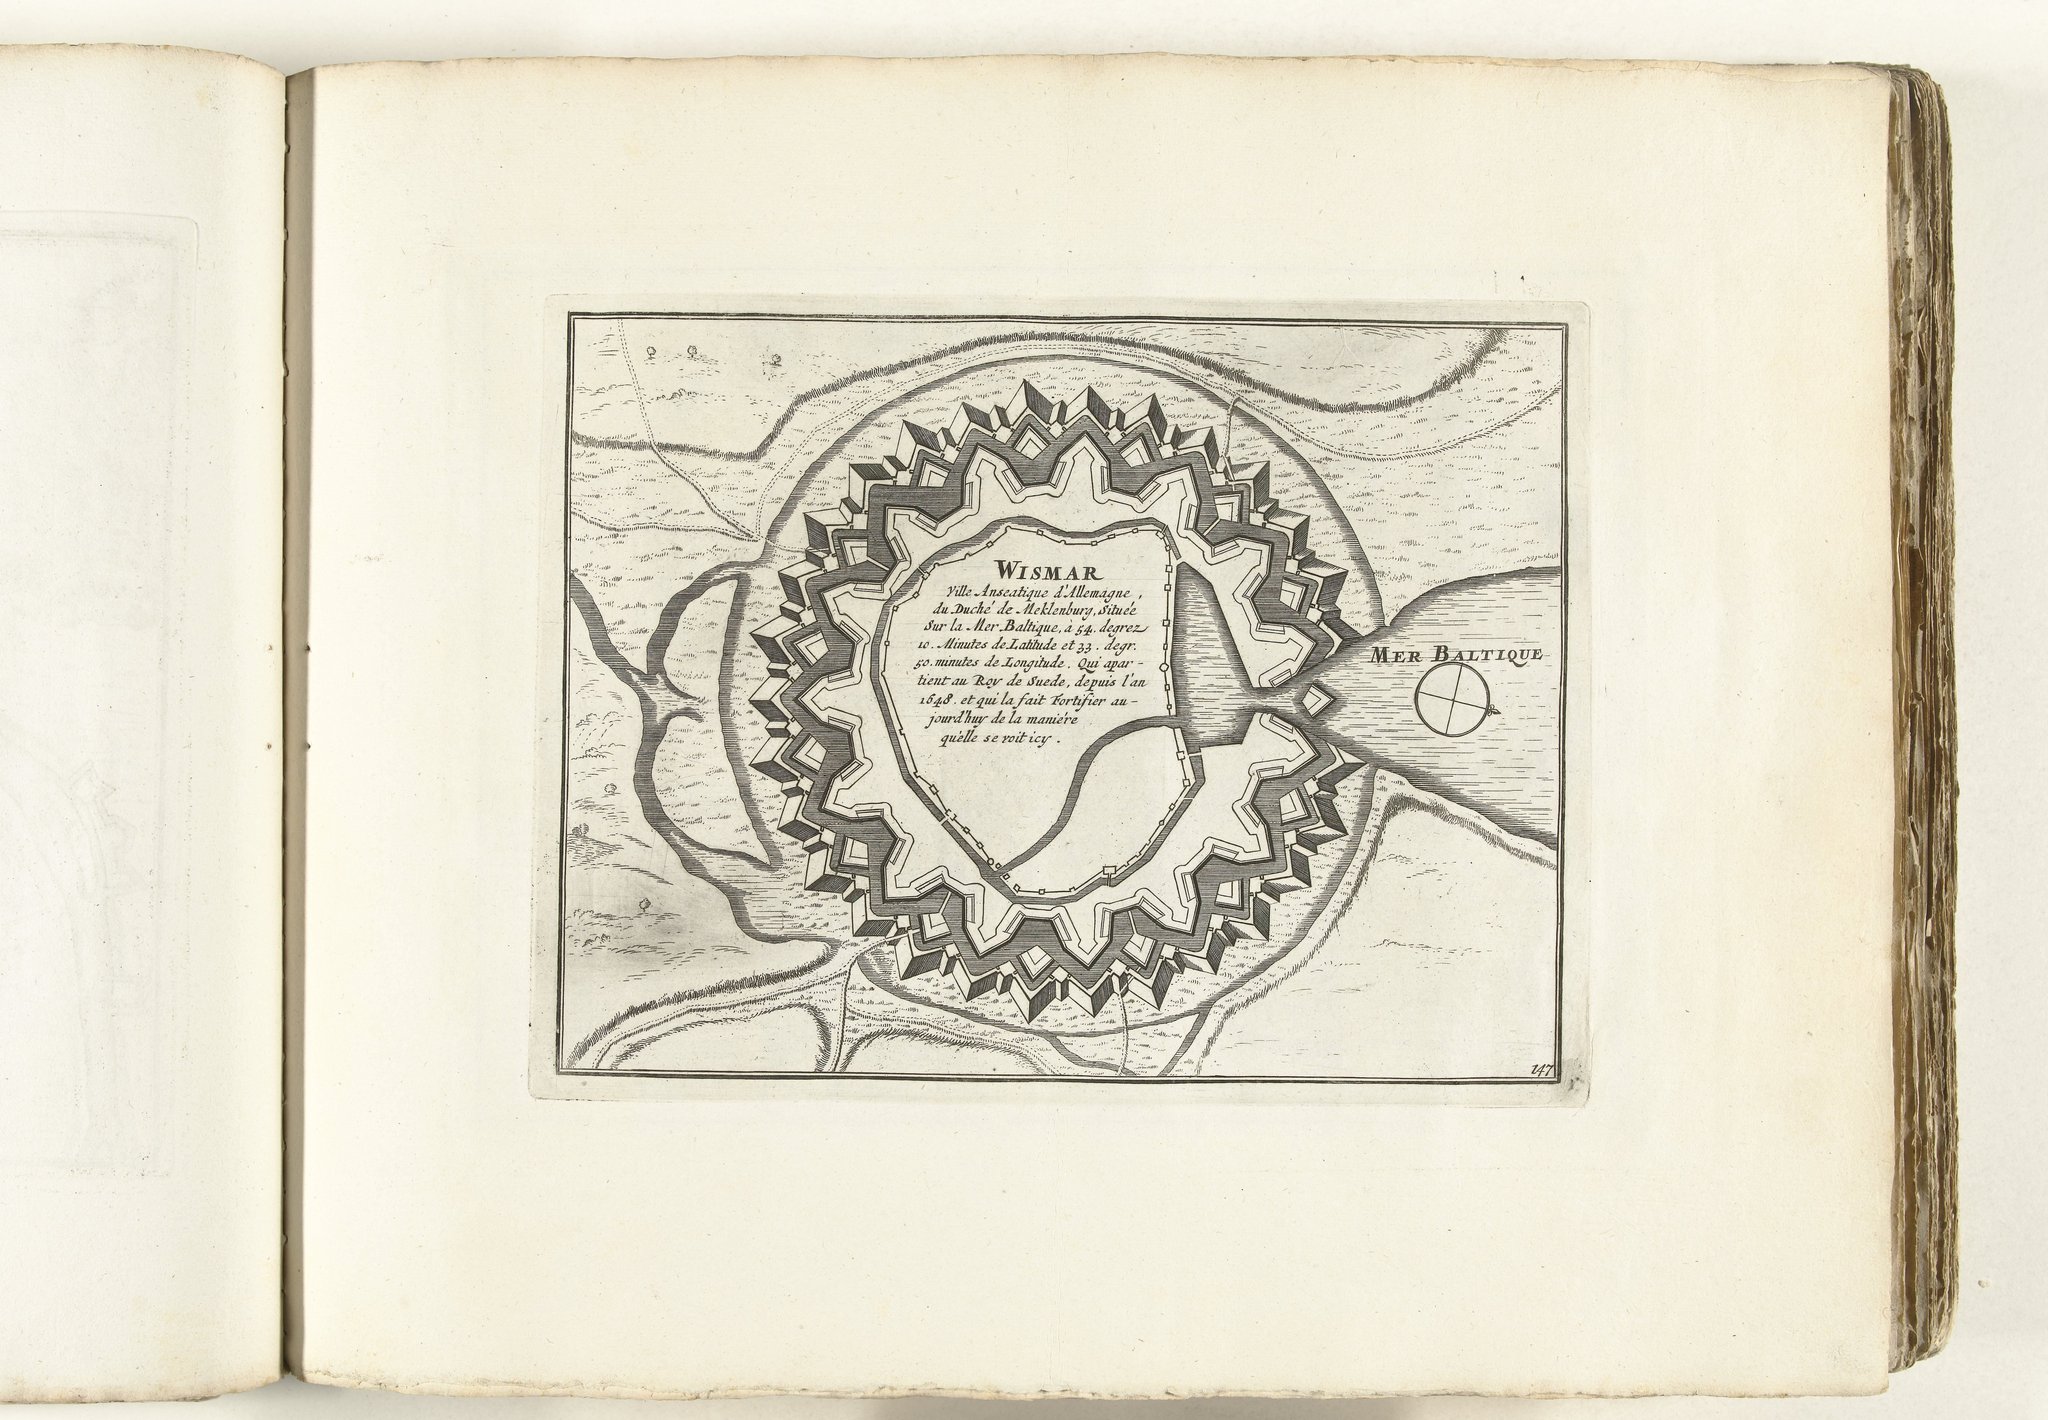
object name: print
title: Plattegrond van Wismar, ca. 1702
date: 1702-1703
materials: paper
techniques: etching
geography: amsterdam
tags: fortress, maps of cities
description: Plattegrond van de versterkingen om de Duitse stad Wismar. Plaat nr. 147 in het prentwerk bestaande in totaal uit 276 genummerde platen van vermaarde sterke steden en vestingen in het kader van de Spaanse Successieoorlog. Voor het merendeel zijn deze platen gekopieerd naar de anonieme Franse platen: in Les forces de l'Europe en in: Le theatre de la guerre, dans les Pays-Bas, beide oorspronkelijk uitgegeven door Nicolas de Fer te Parijs (1693-1697) in het kader van de Negenjarige Oorlog. Titel en opschriften in de plaat in het Frans.